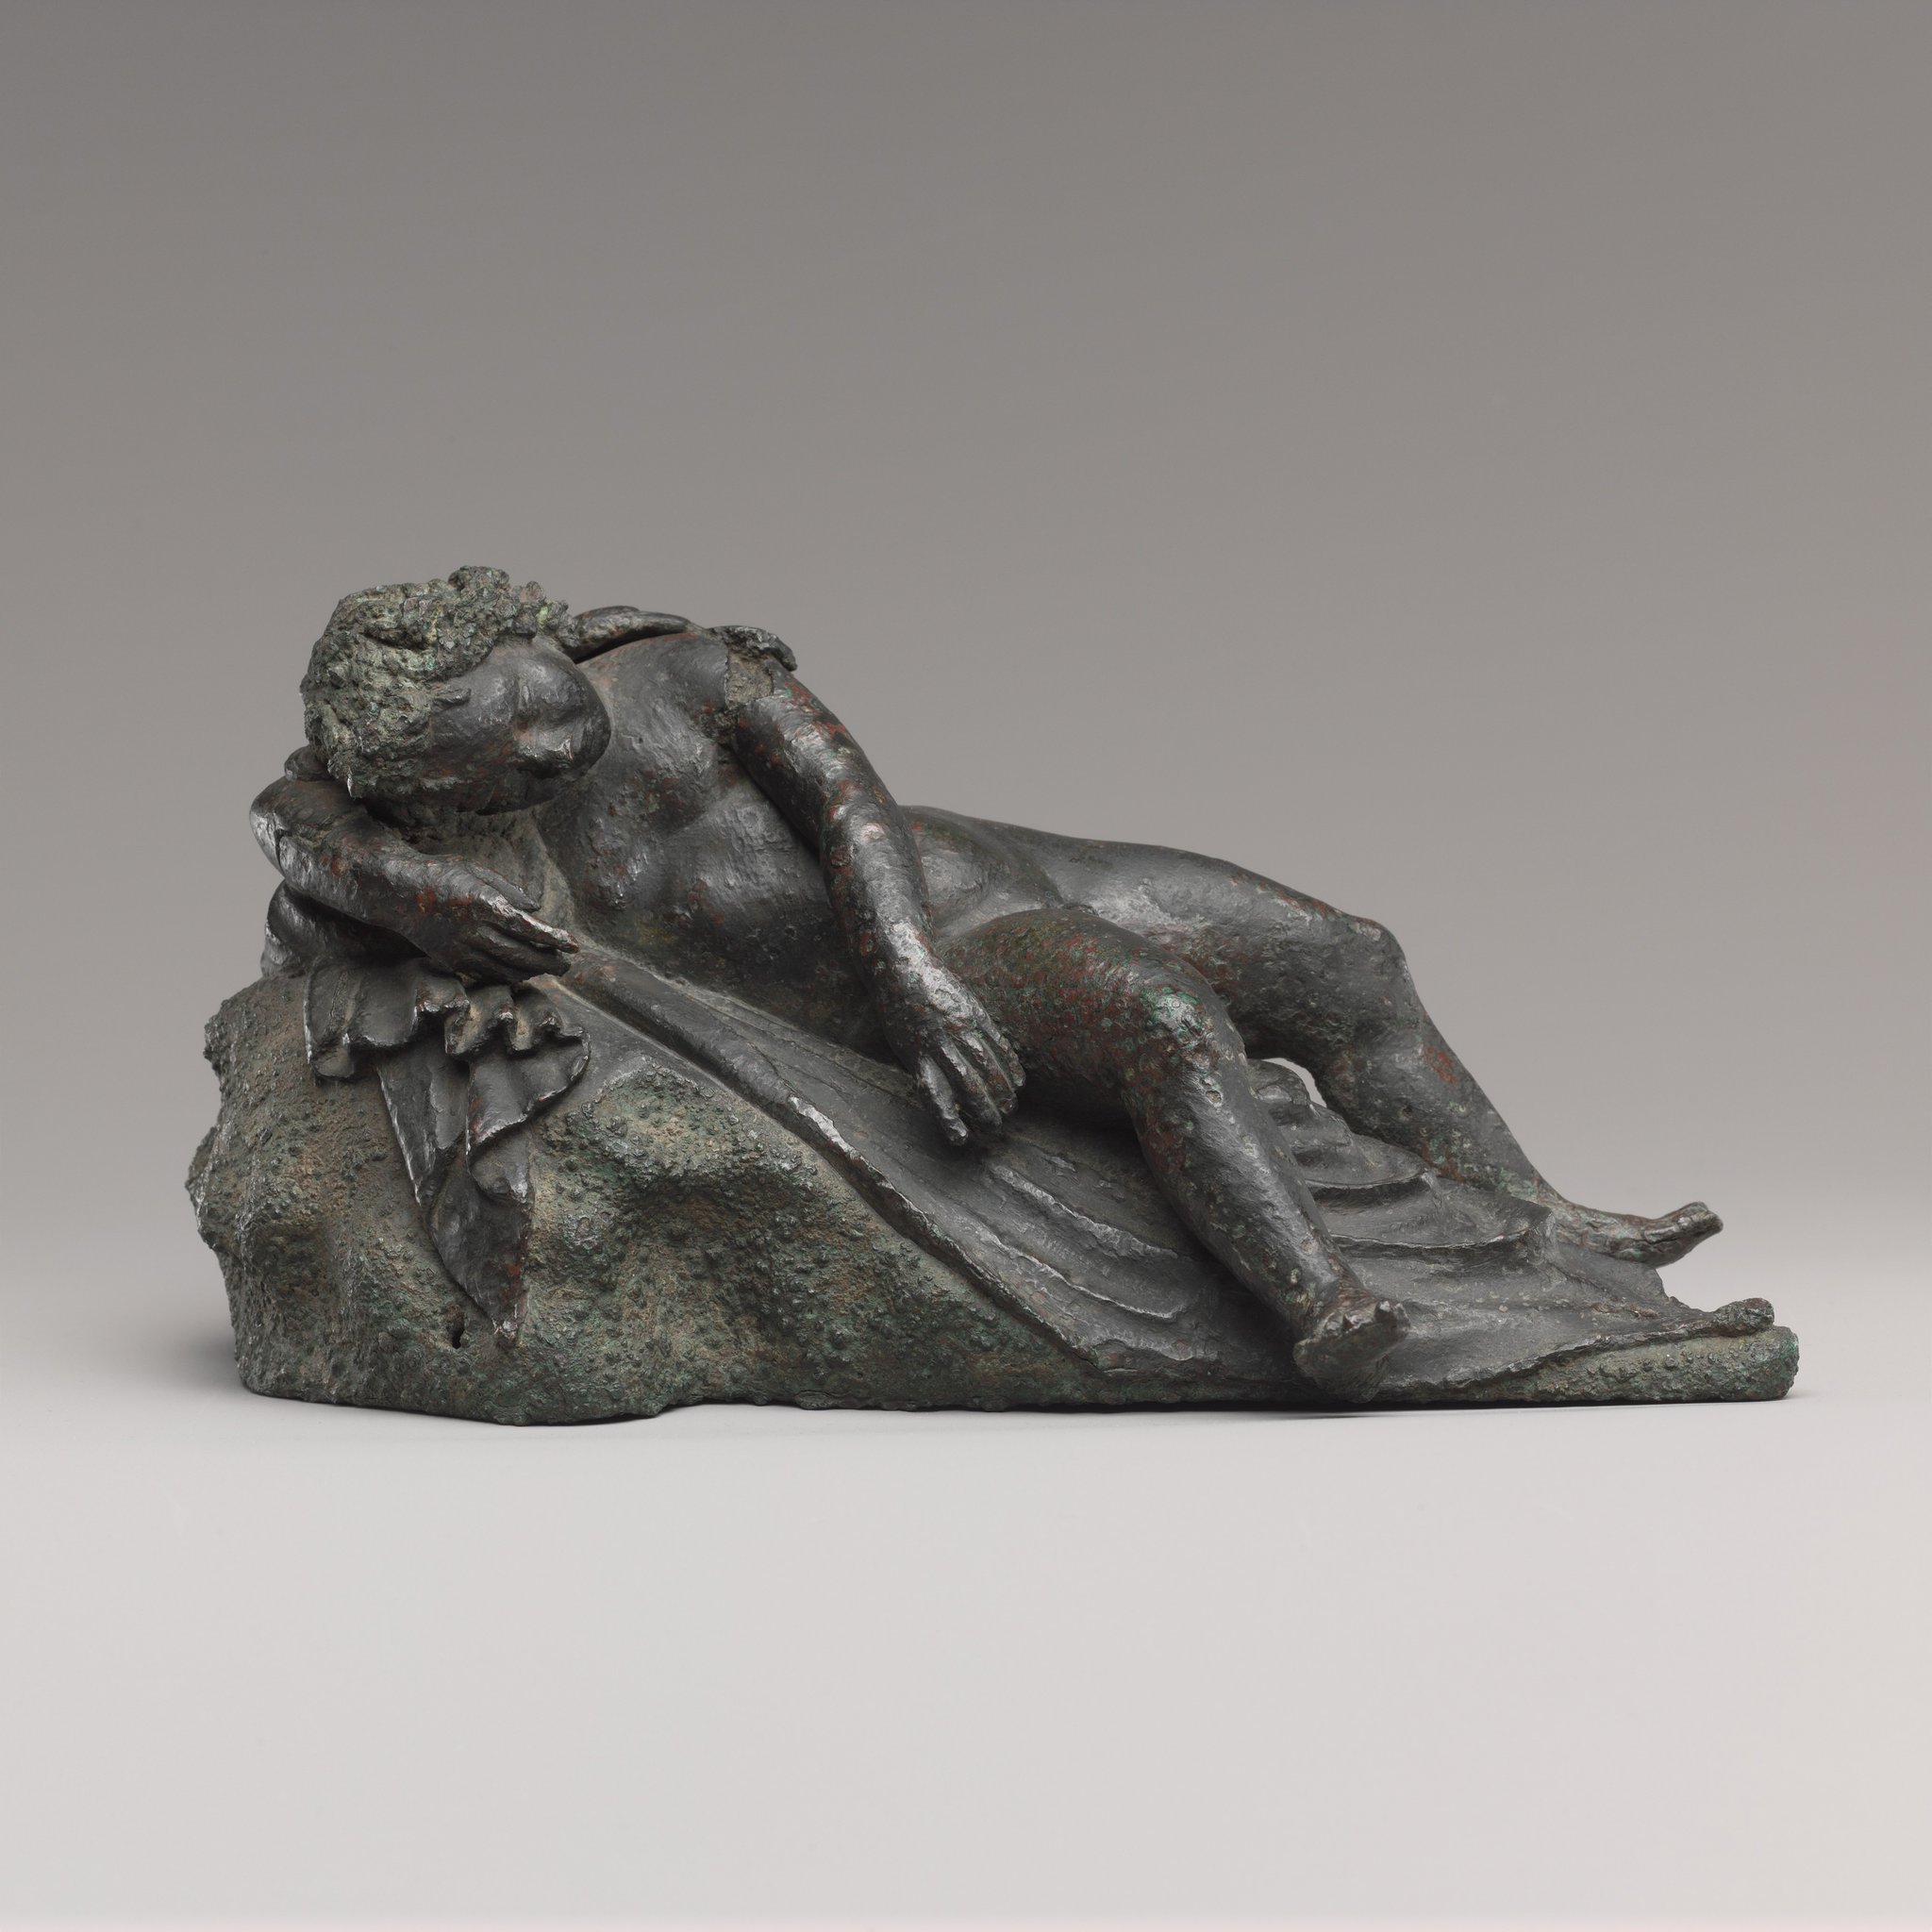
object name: statuette of eros sleeping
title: Bronze statuette of Eros sleeping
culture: greek or roman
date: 100 BCE-200 CE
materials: bronze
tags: sleeping,eros